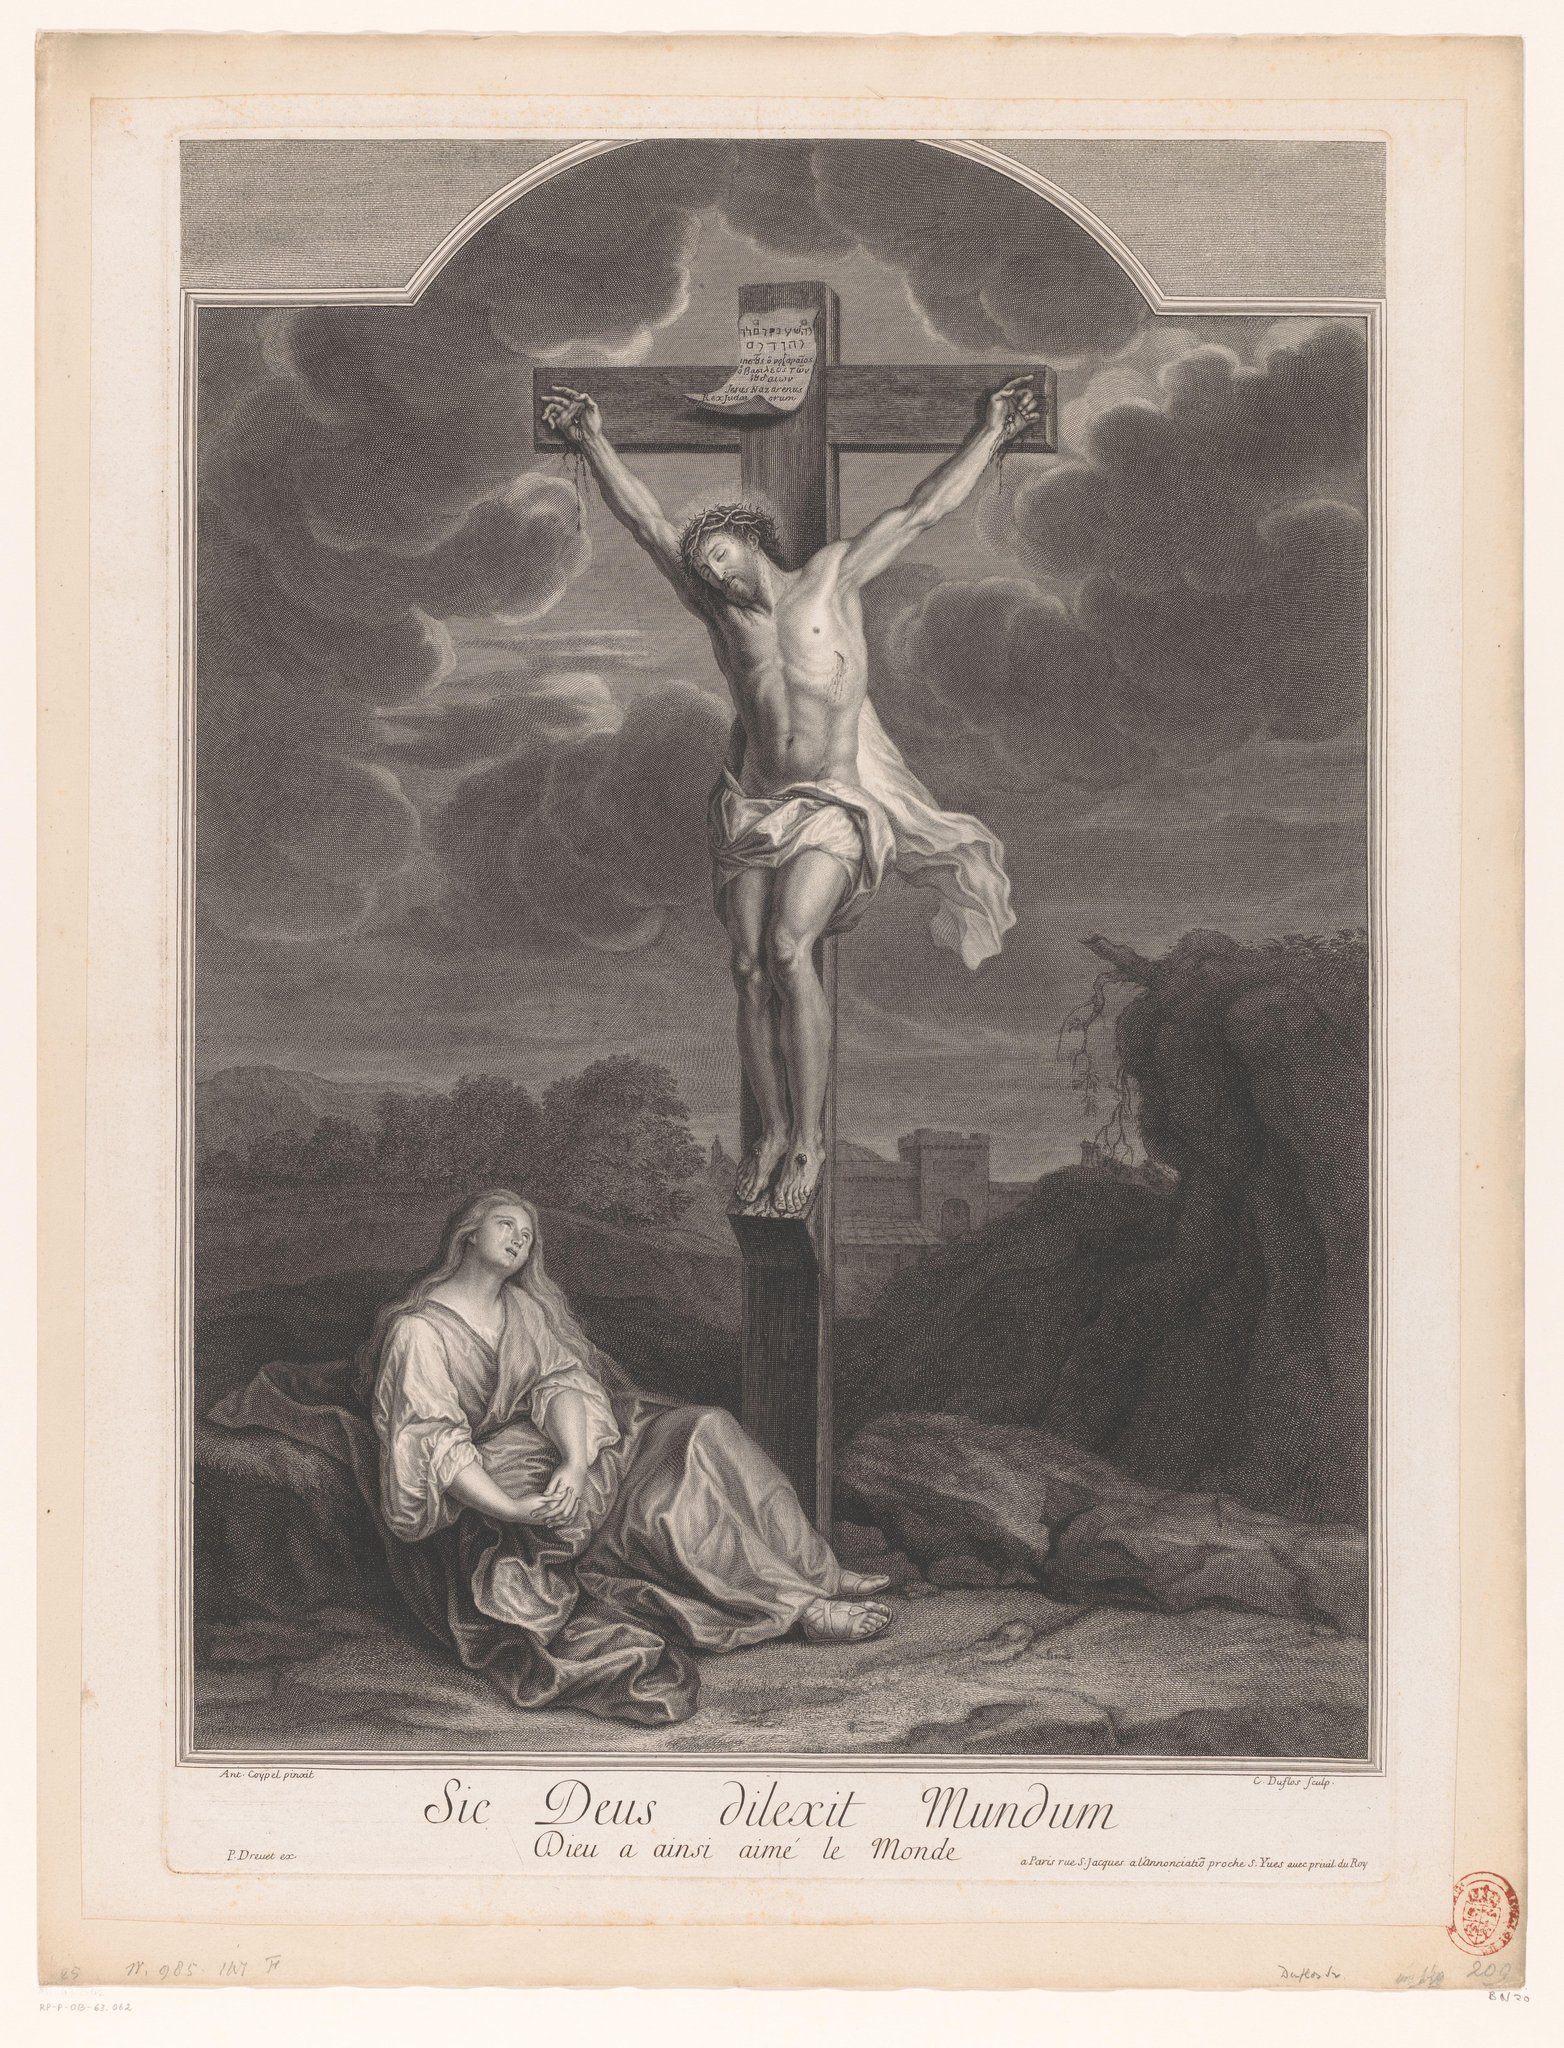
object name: print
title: Christus aan het kruis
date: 1675-1727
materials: paper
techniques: engraving, etching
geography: paris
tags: crucified christ with mary magdalene, who usually weeps and embraces the cross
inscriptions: collector's mark: Lugt 240